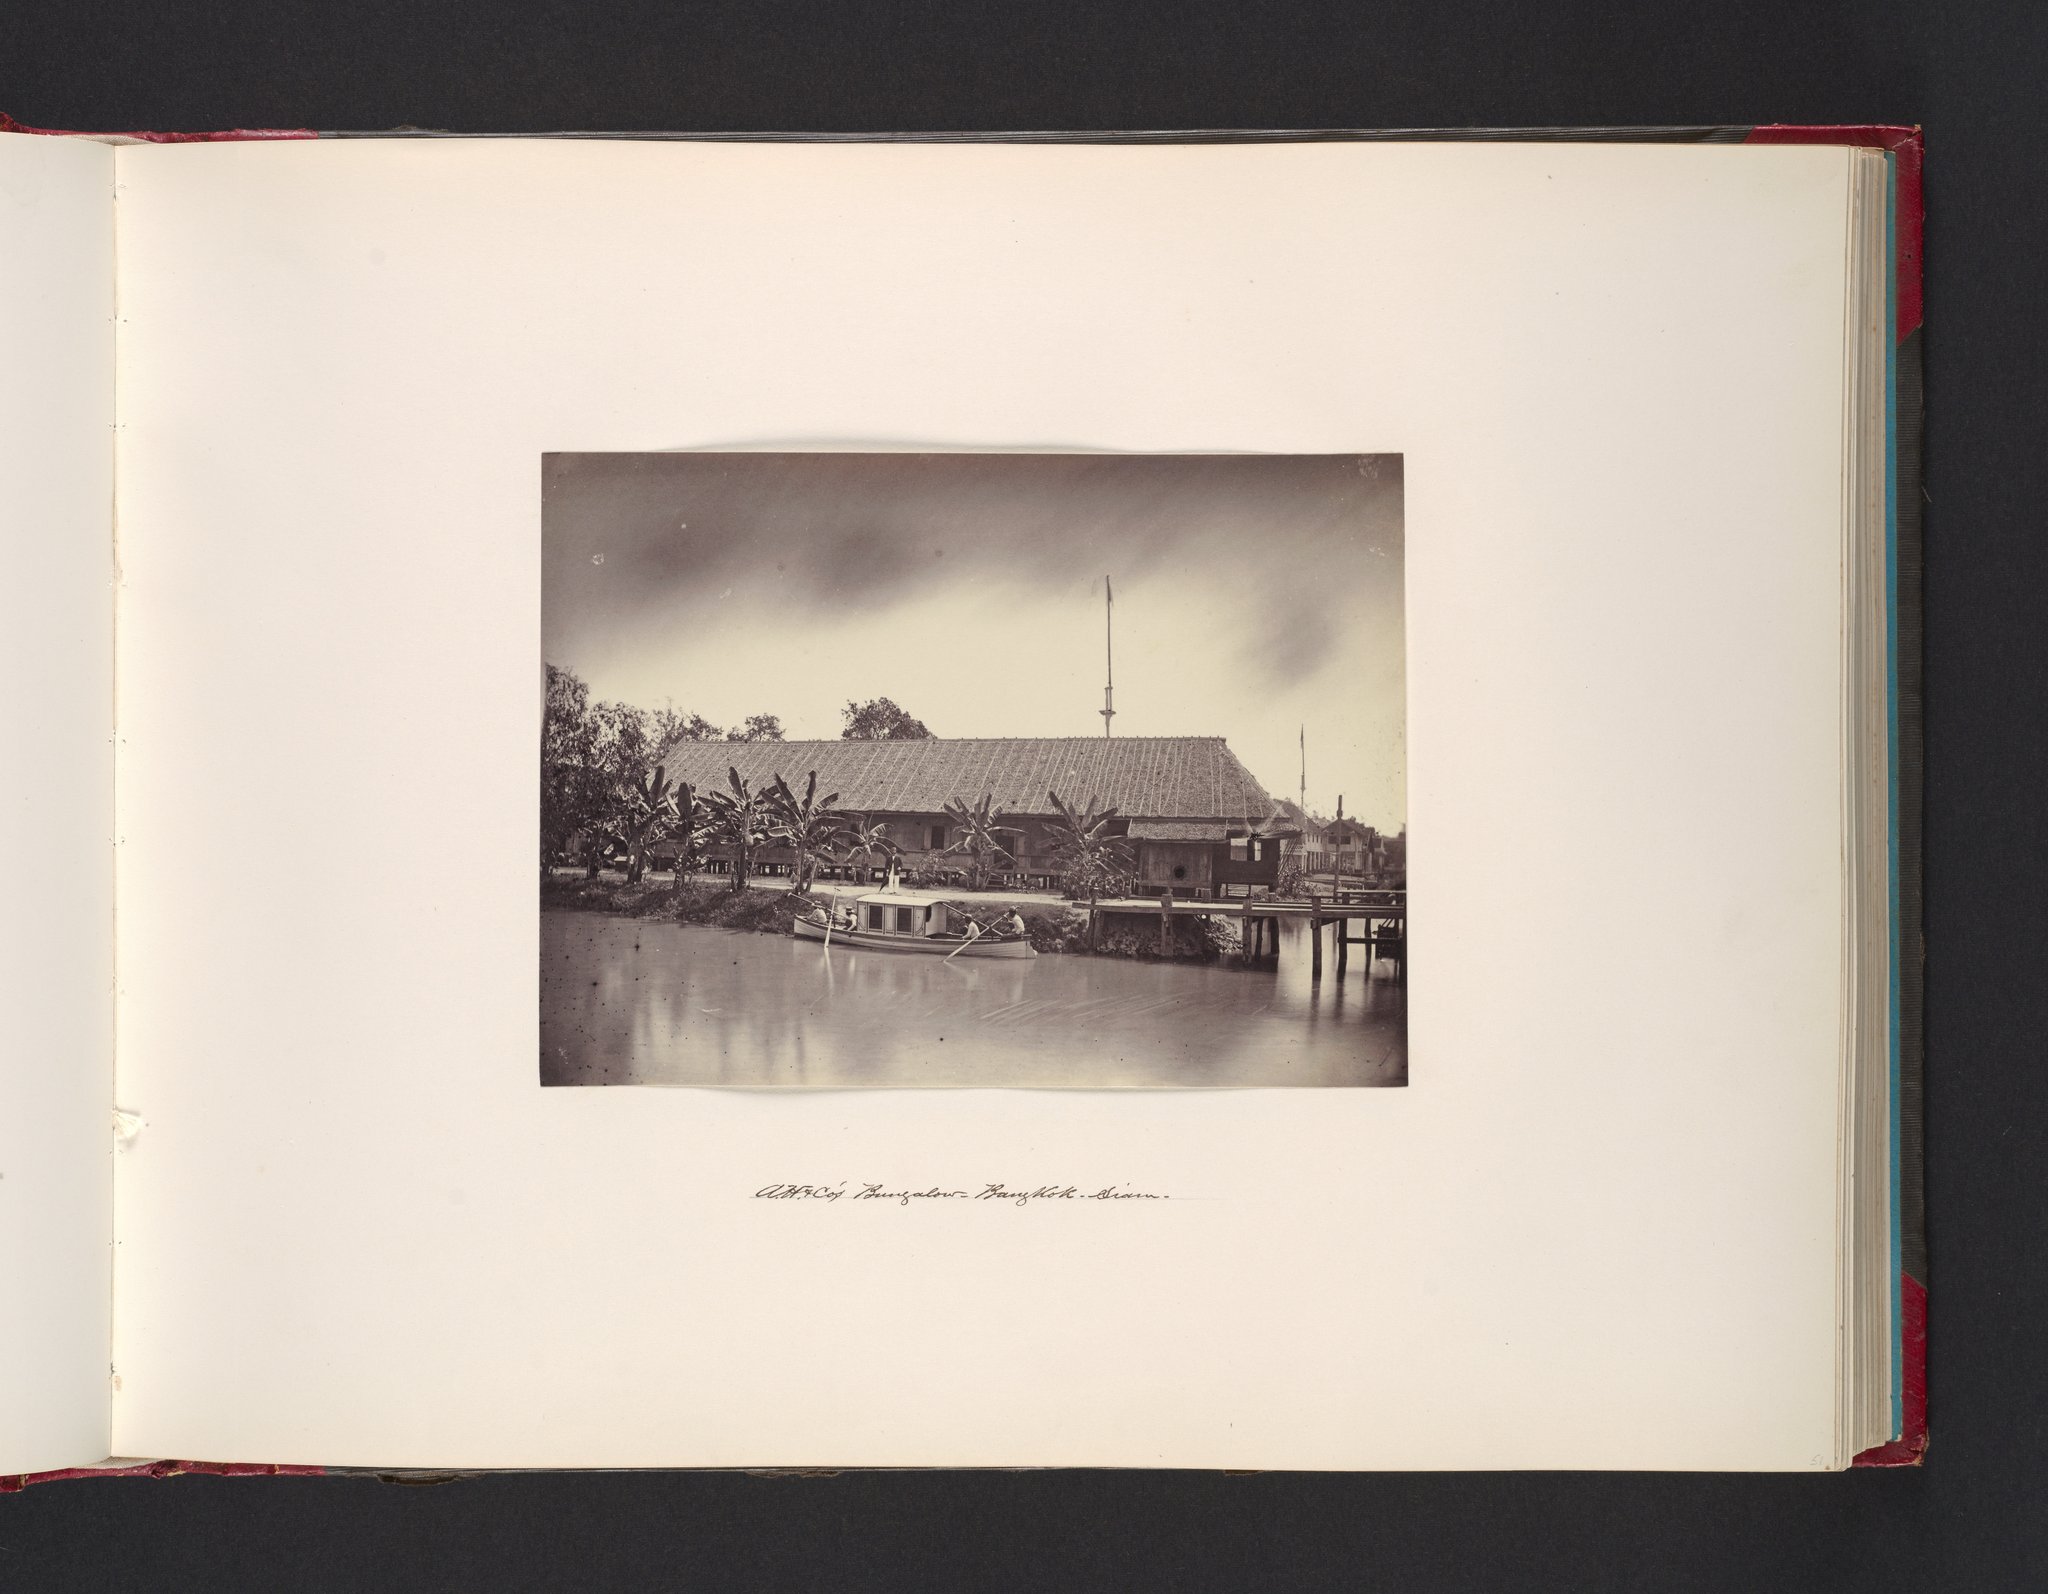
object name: photograph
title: Augustine Heard & Co. Bungalow, Bangkok, Siam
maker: john thomson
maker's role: artist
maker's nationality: british, scottish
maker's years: 1837-1921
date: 1865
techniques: albumen silver print, glass negative